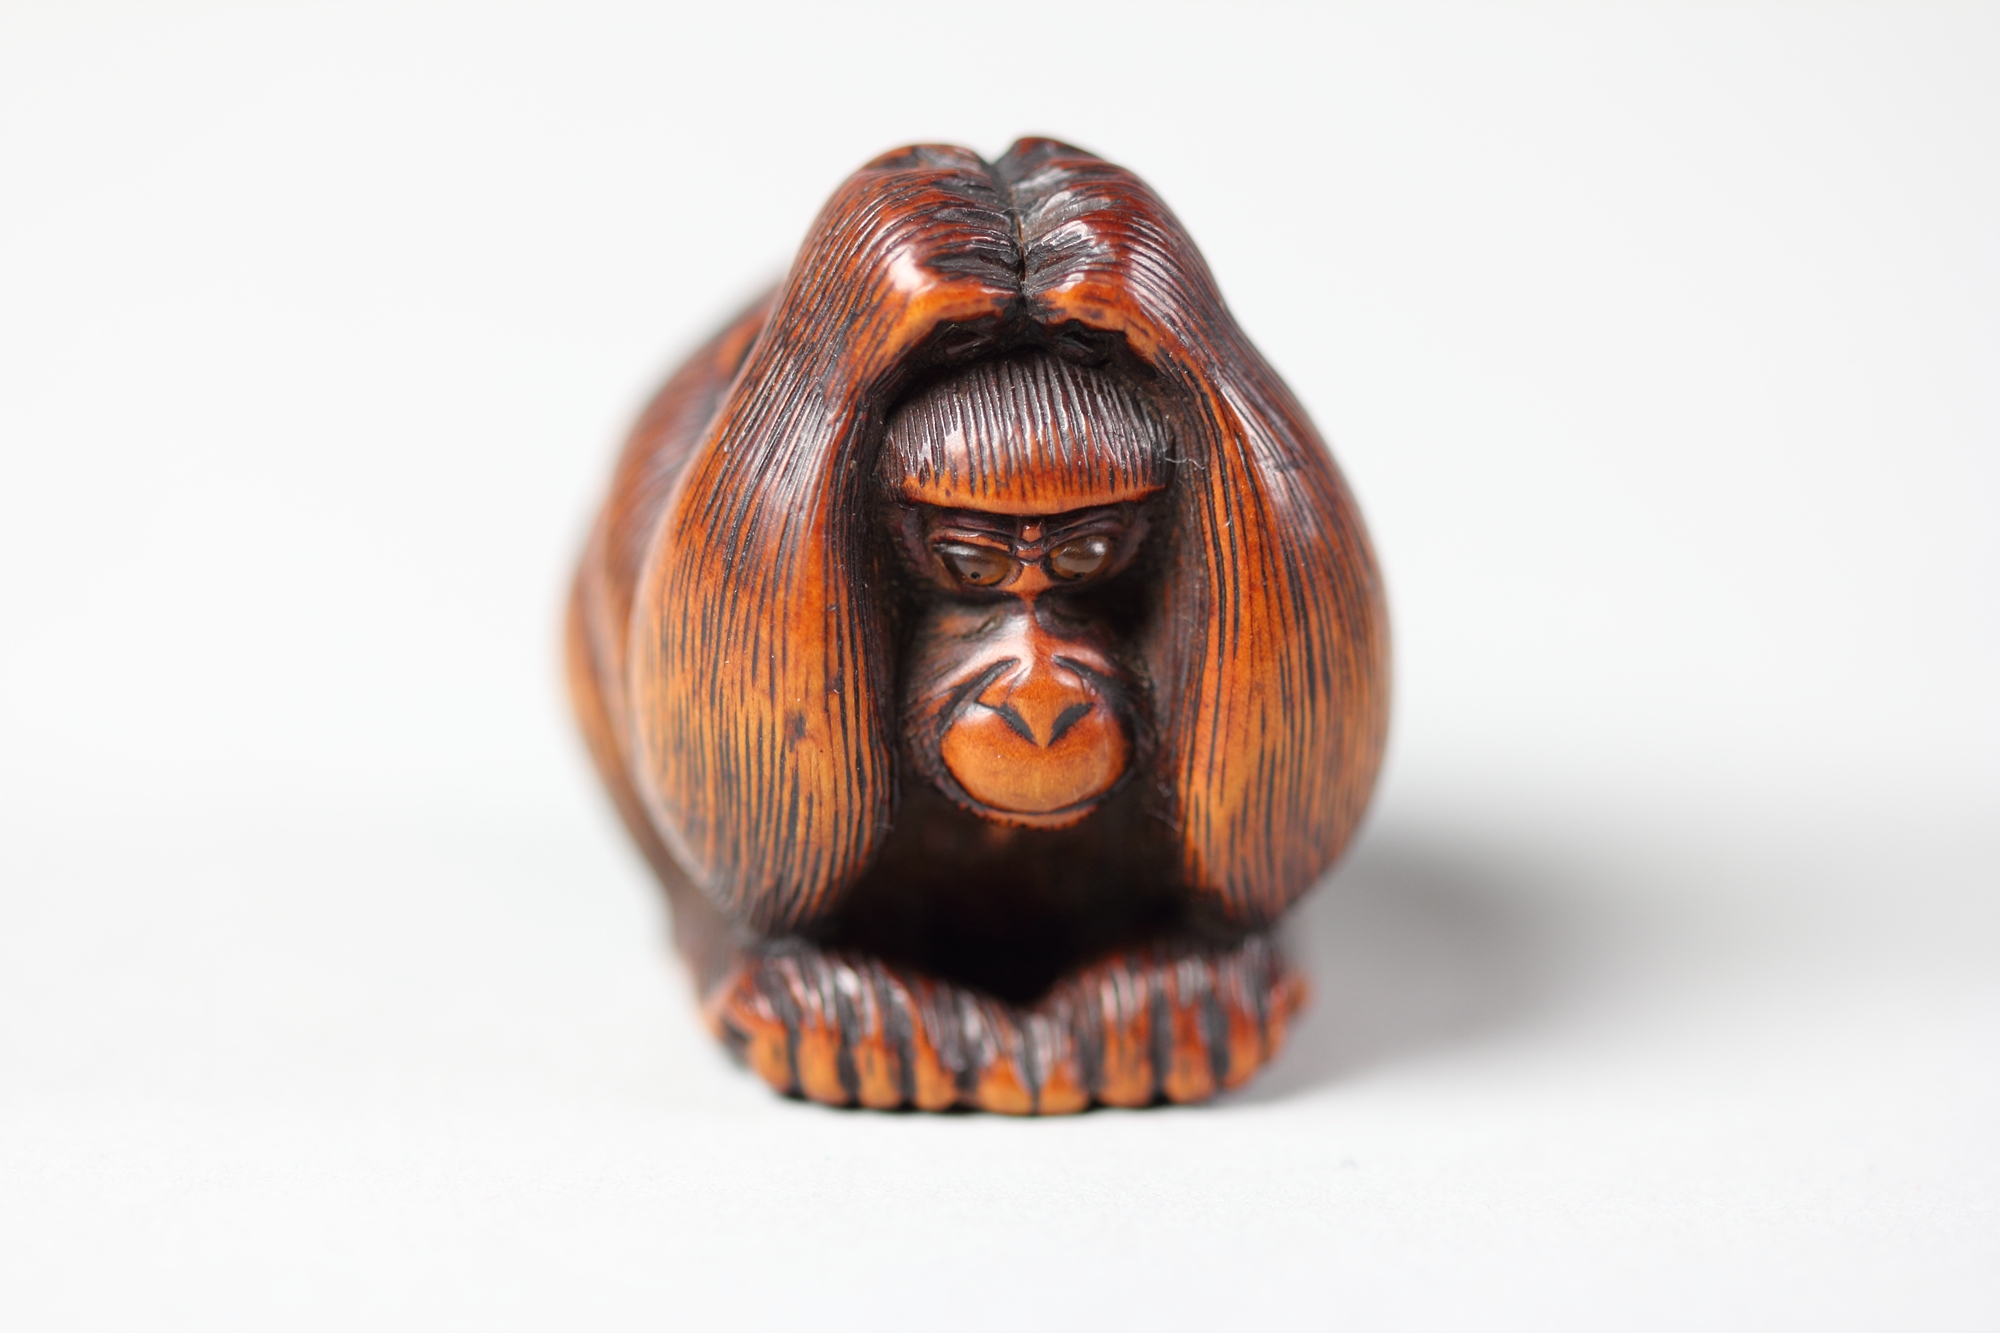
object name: netsuke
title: Netsuke of Monkey Scratching His Head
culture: japanese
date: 1801-1900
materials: wood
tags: monkeys